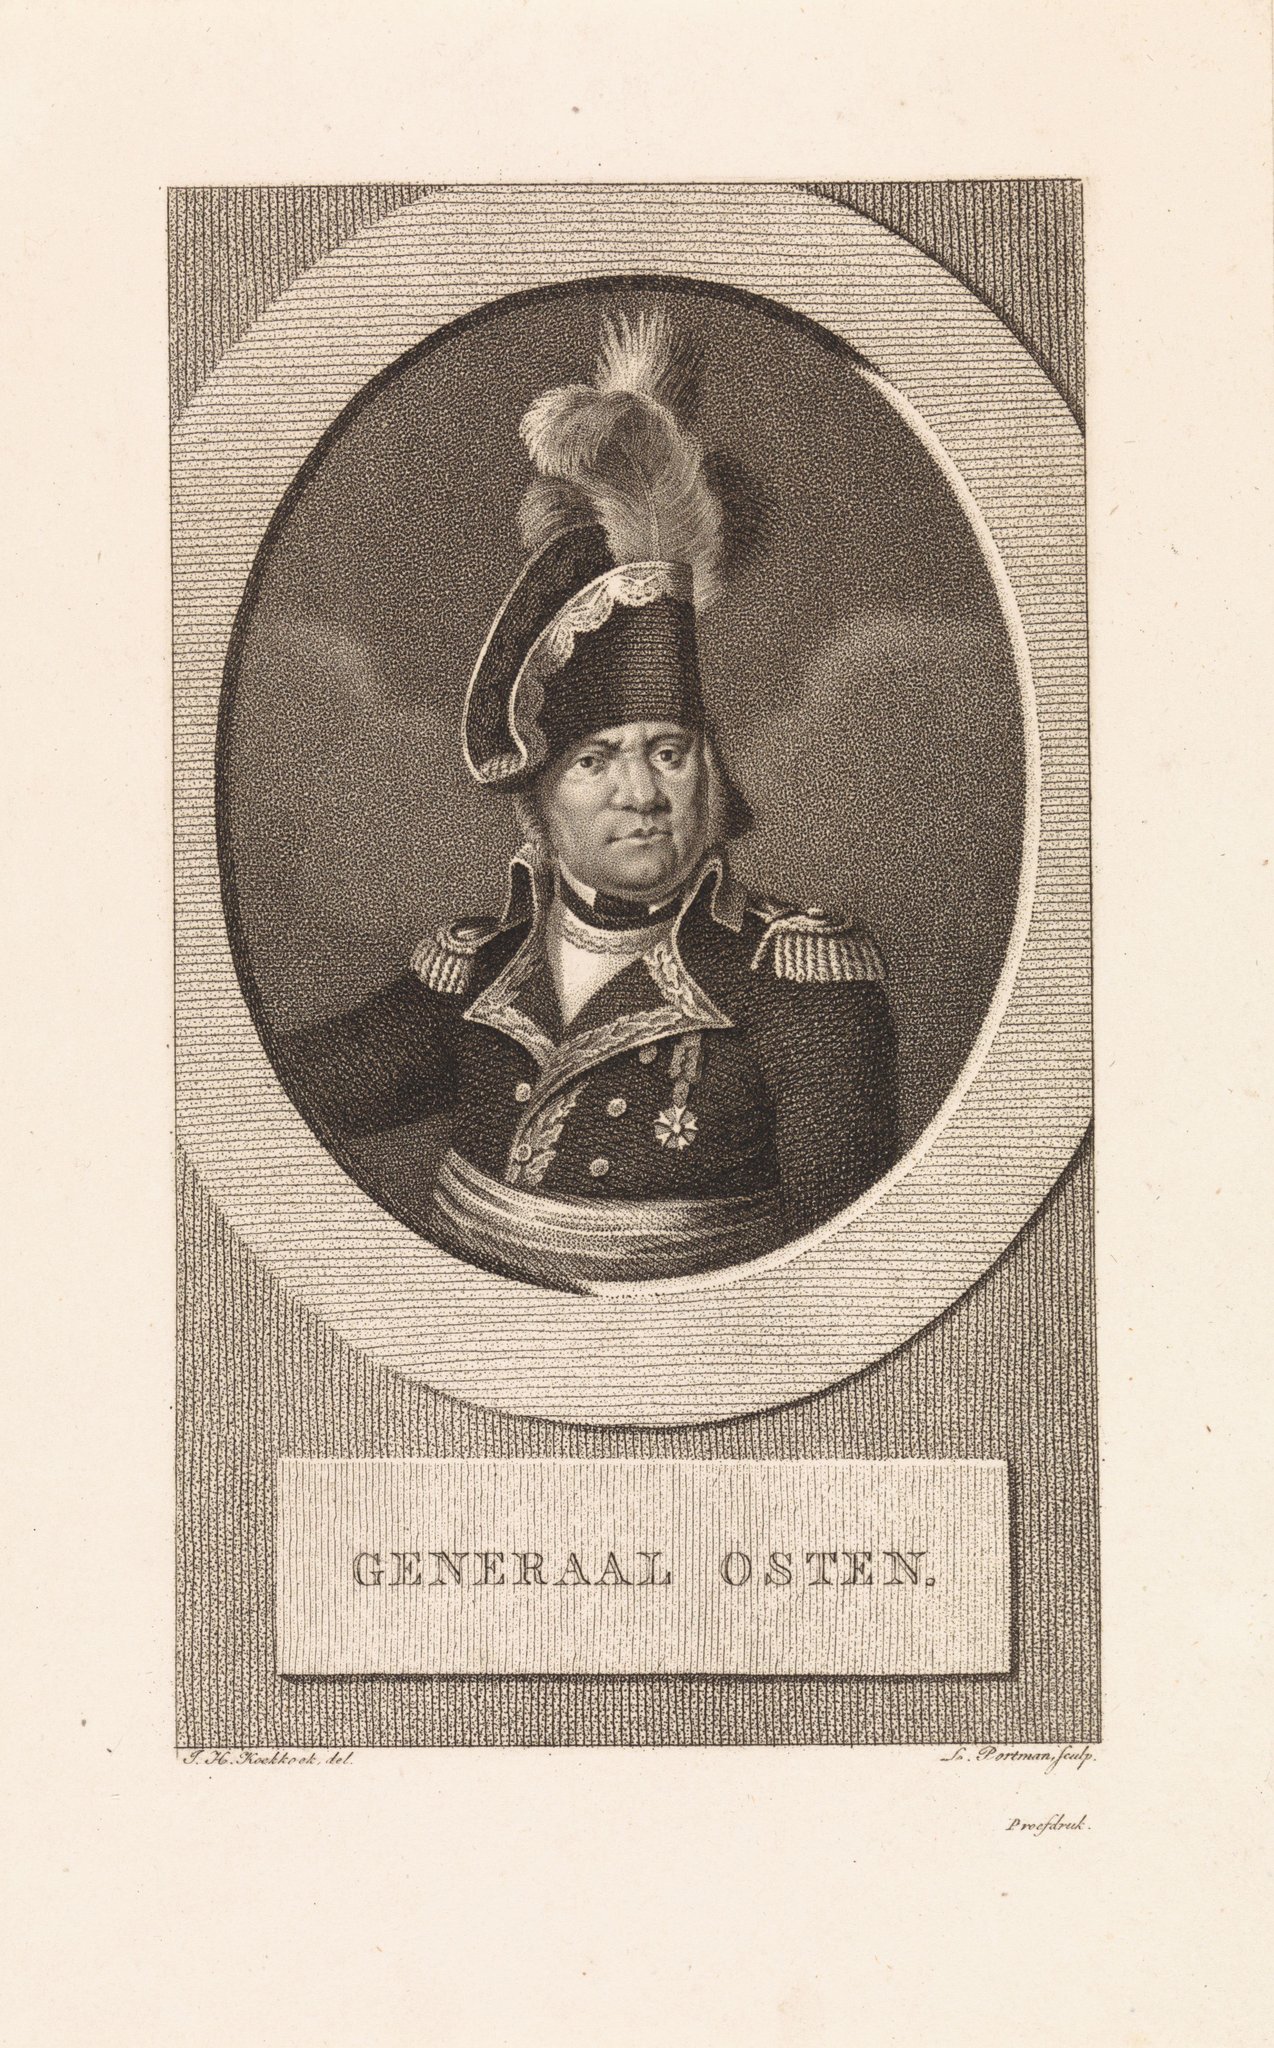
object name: print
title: Portret van de generaal Pierre-Jacques Osten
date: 1787-1828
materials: paper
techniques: etching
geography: netherlands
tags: menin, generaal, pierre-jacques osten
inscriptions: collector's mark: Lugt 2228